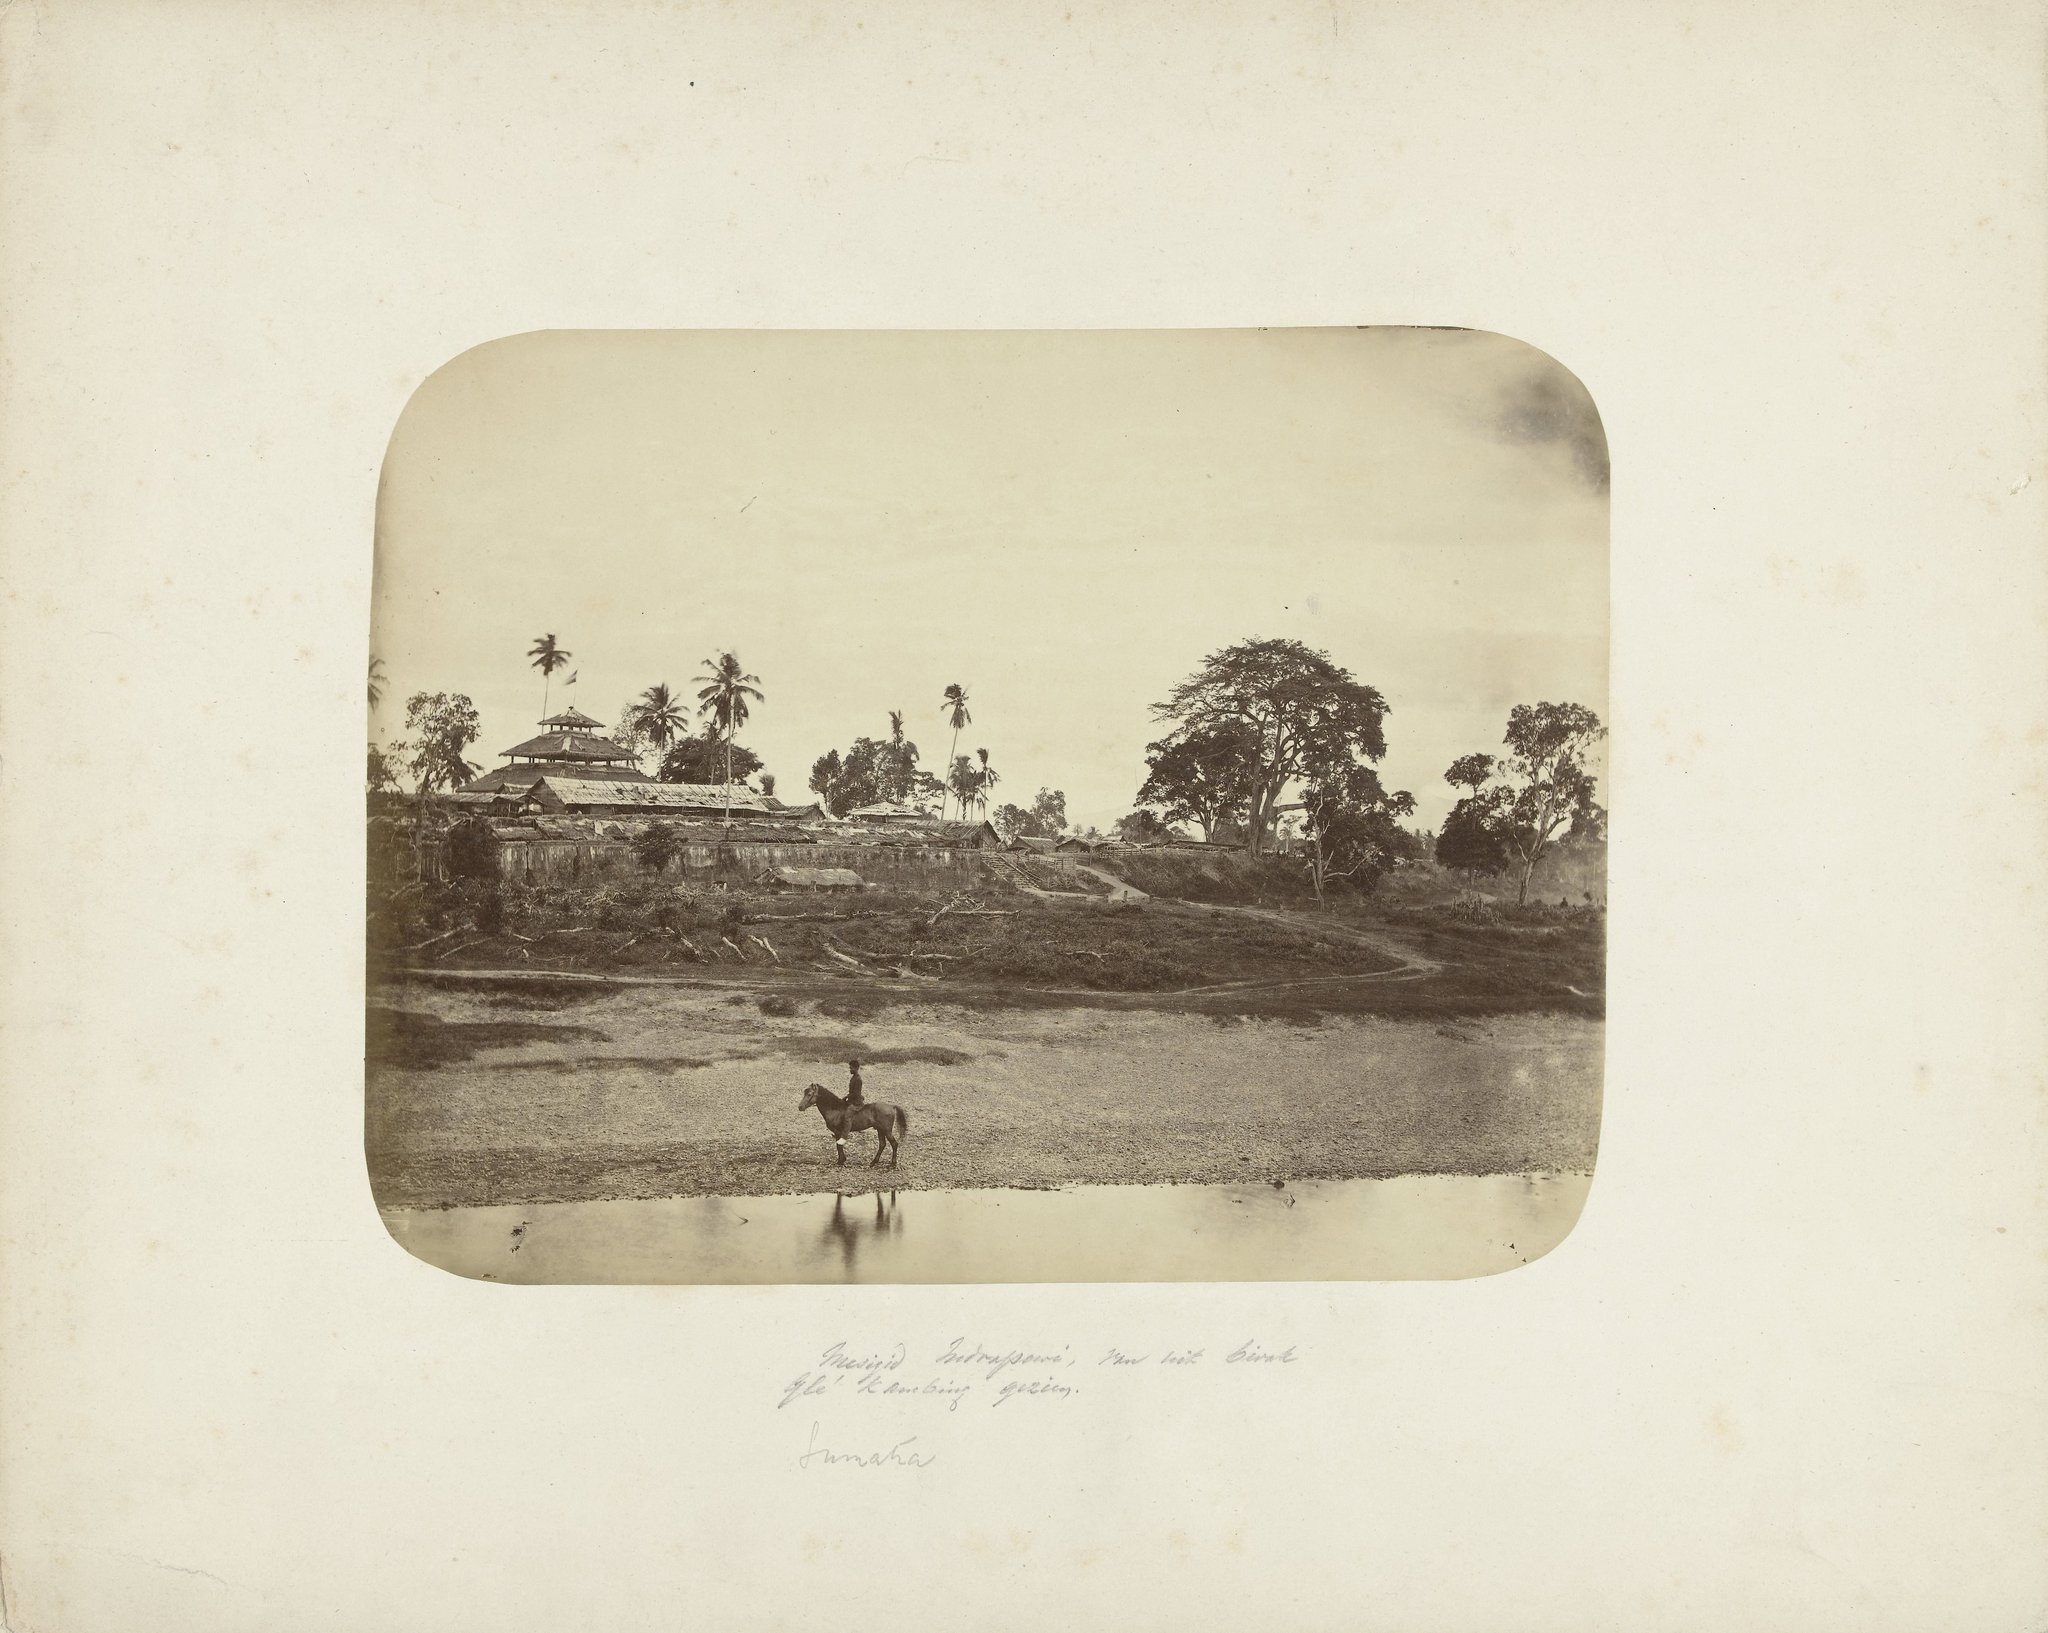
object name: photograph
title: Moskee van Indrapuri, gezien vanuit bivak Gle Kambing, Atjeh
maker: Anonymous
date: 1870-1900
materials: cardboard, paper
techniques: albumen print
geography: aceh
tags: temple, shrine ~ islam, mohammedanism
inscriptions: inscription: ‘Mesigid Indrapouri, van uit bivak/ Gle' Kambing gezien./ Sumatra’